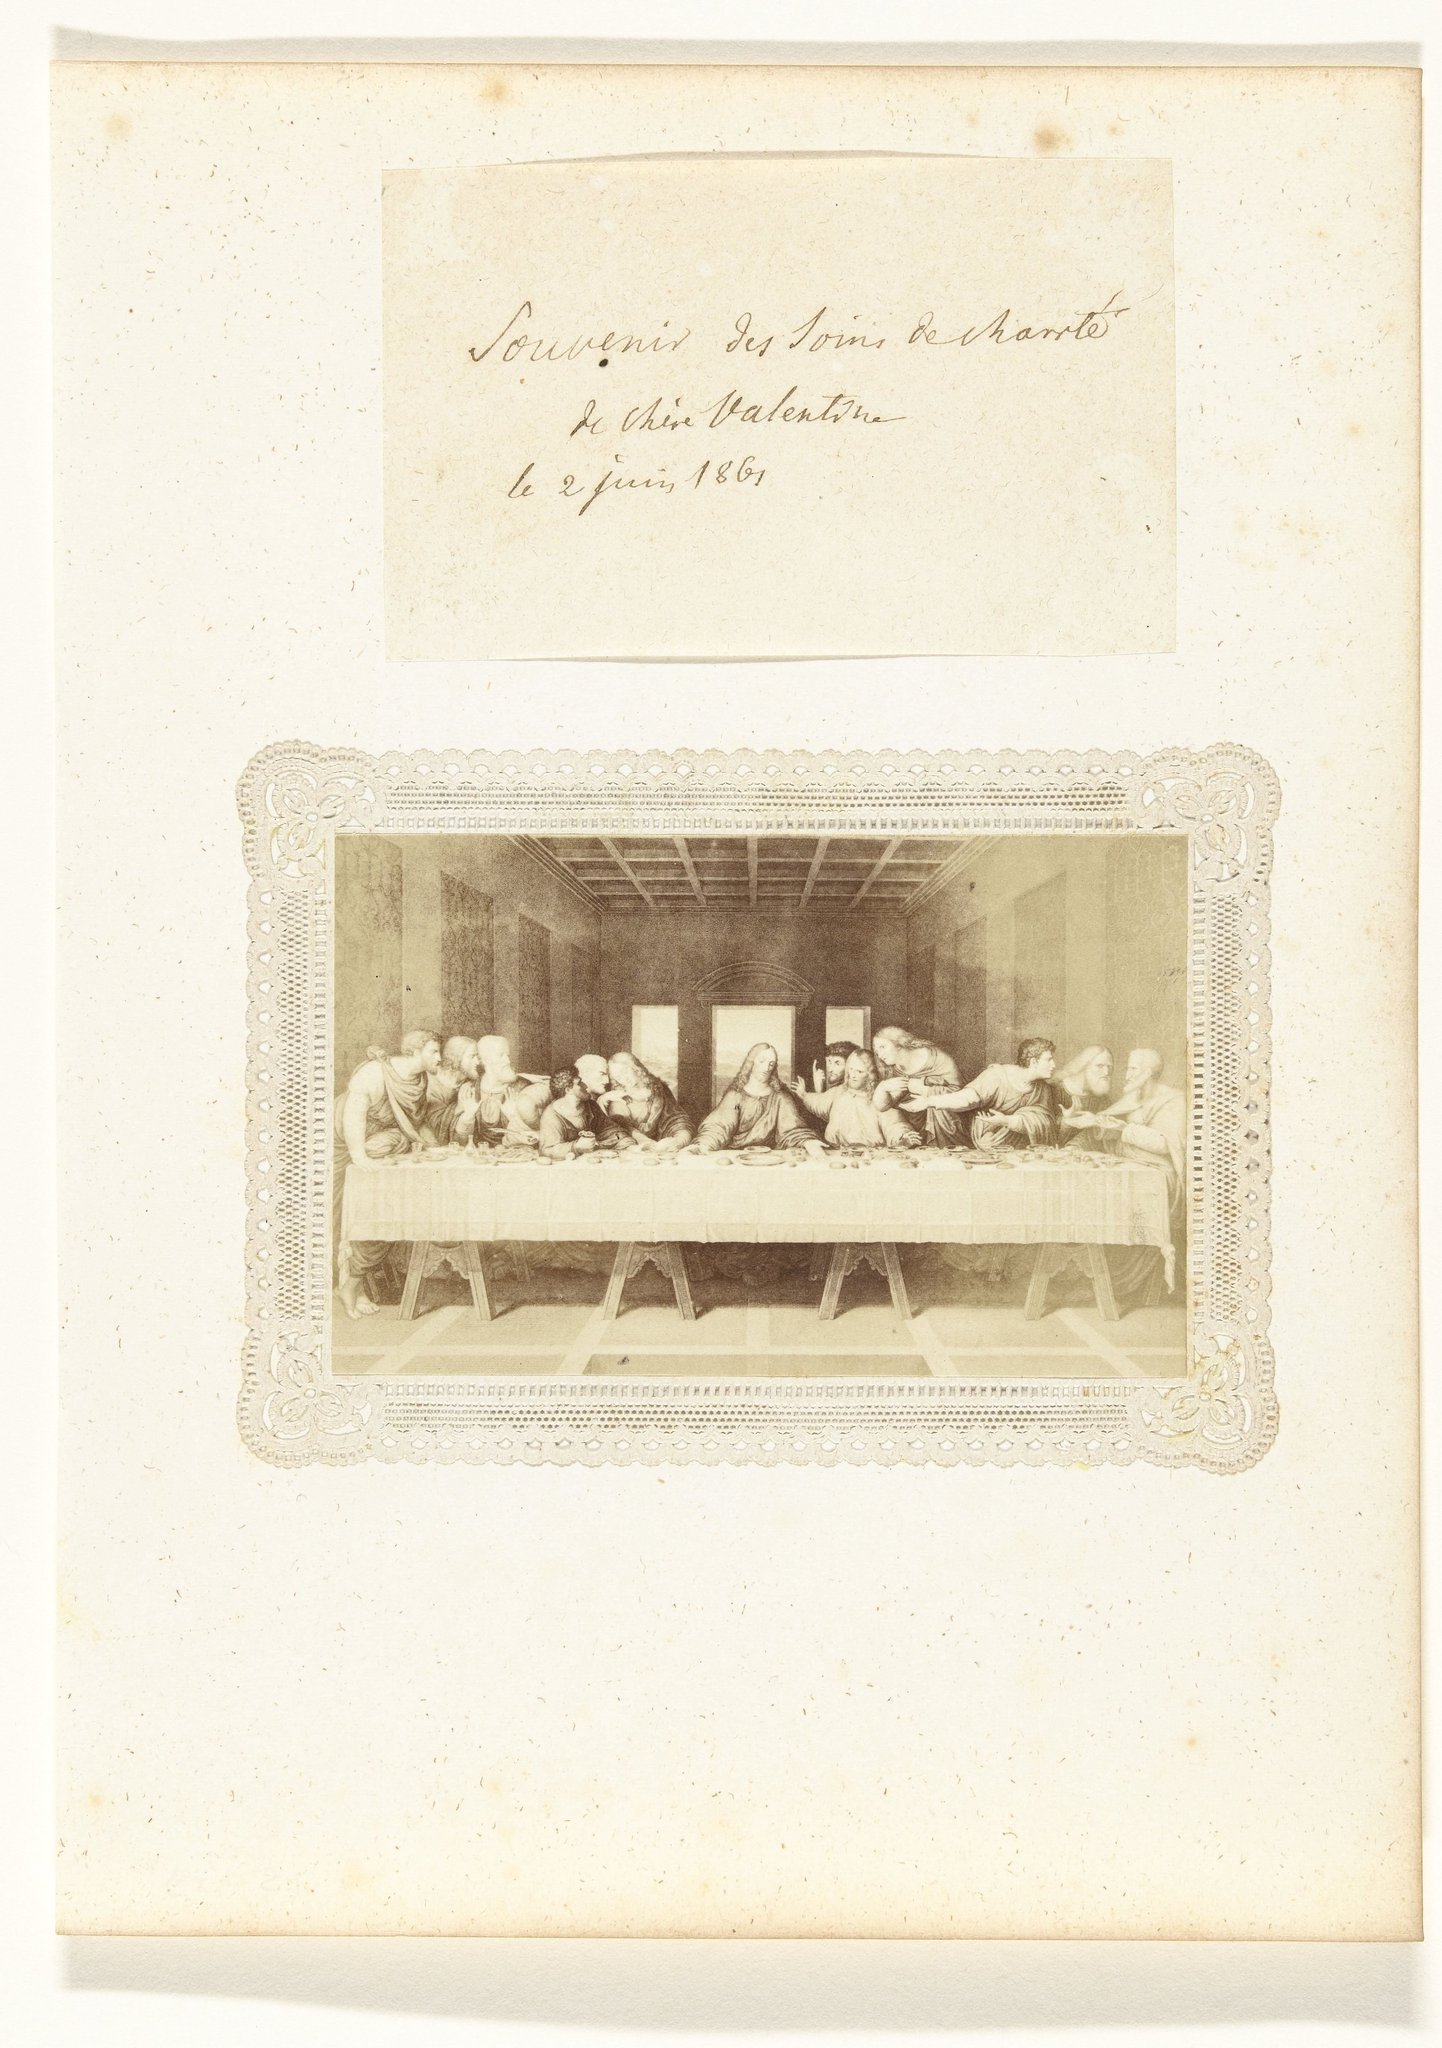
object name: prayer card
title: Fotoreproductie van het fresco 'het Laatste Avondmaal' van Leonardo da Vinci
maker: Anonymous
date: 1861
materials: paper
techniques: albumen print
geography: france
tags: last supper (in general) (matthew 26:21-35; mark 14:18-31; luke 22:3, 22:15-23; john 13:21-38)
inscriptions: inscription: ‘Souvenir des Soins de Charité/ De Chine Valentine/ le 2 juin 1861’